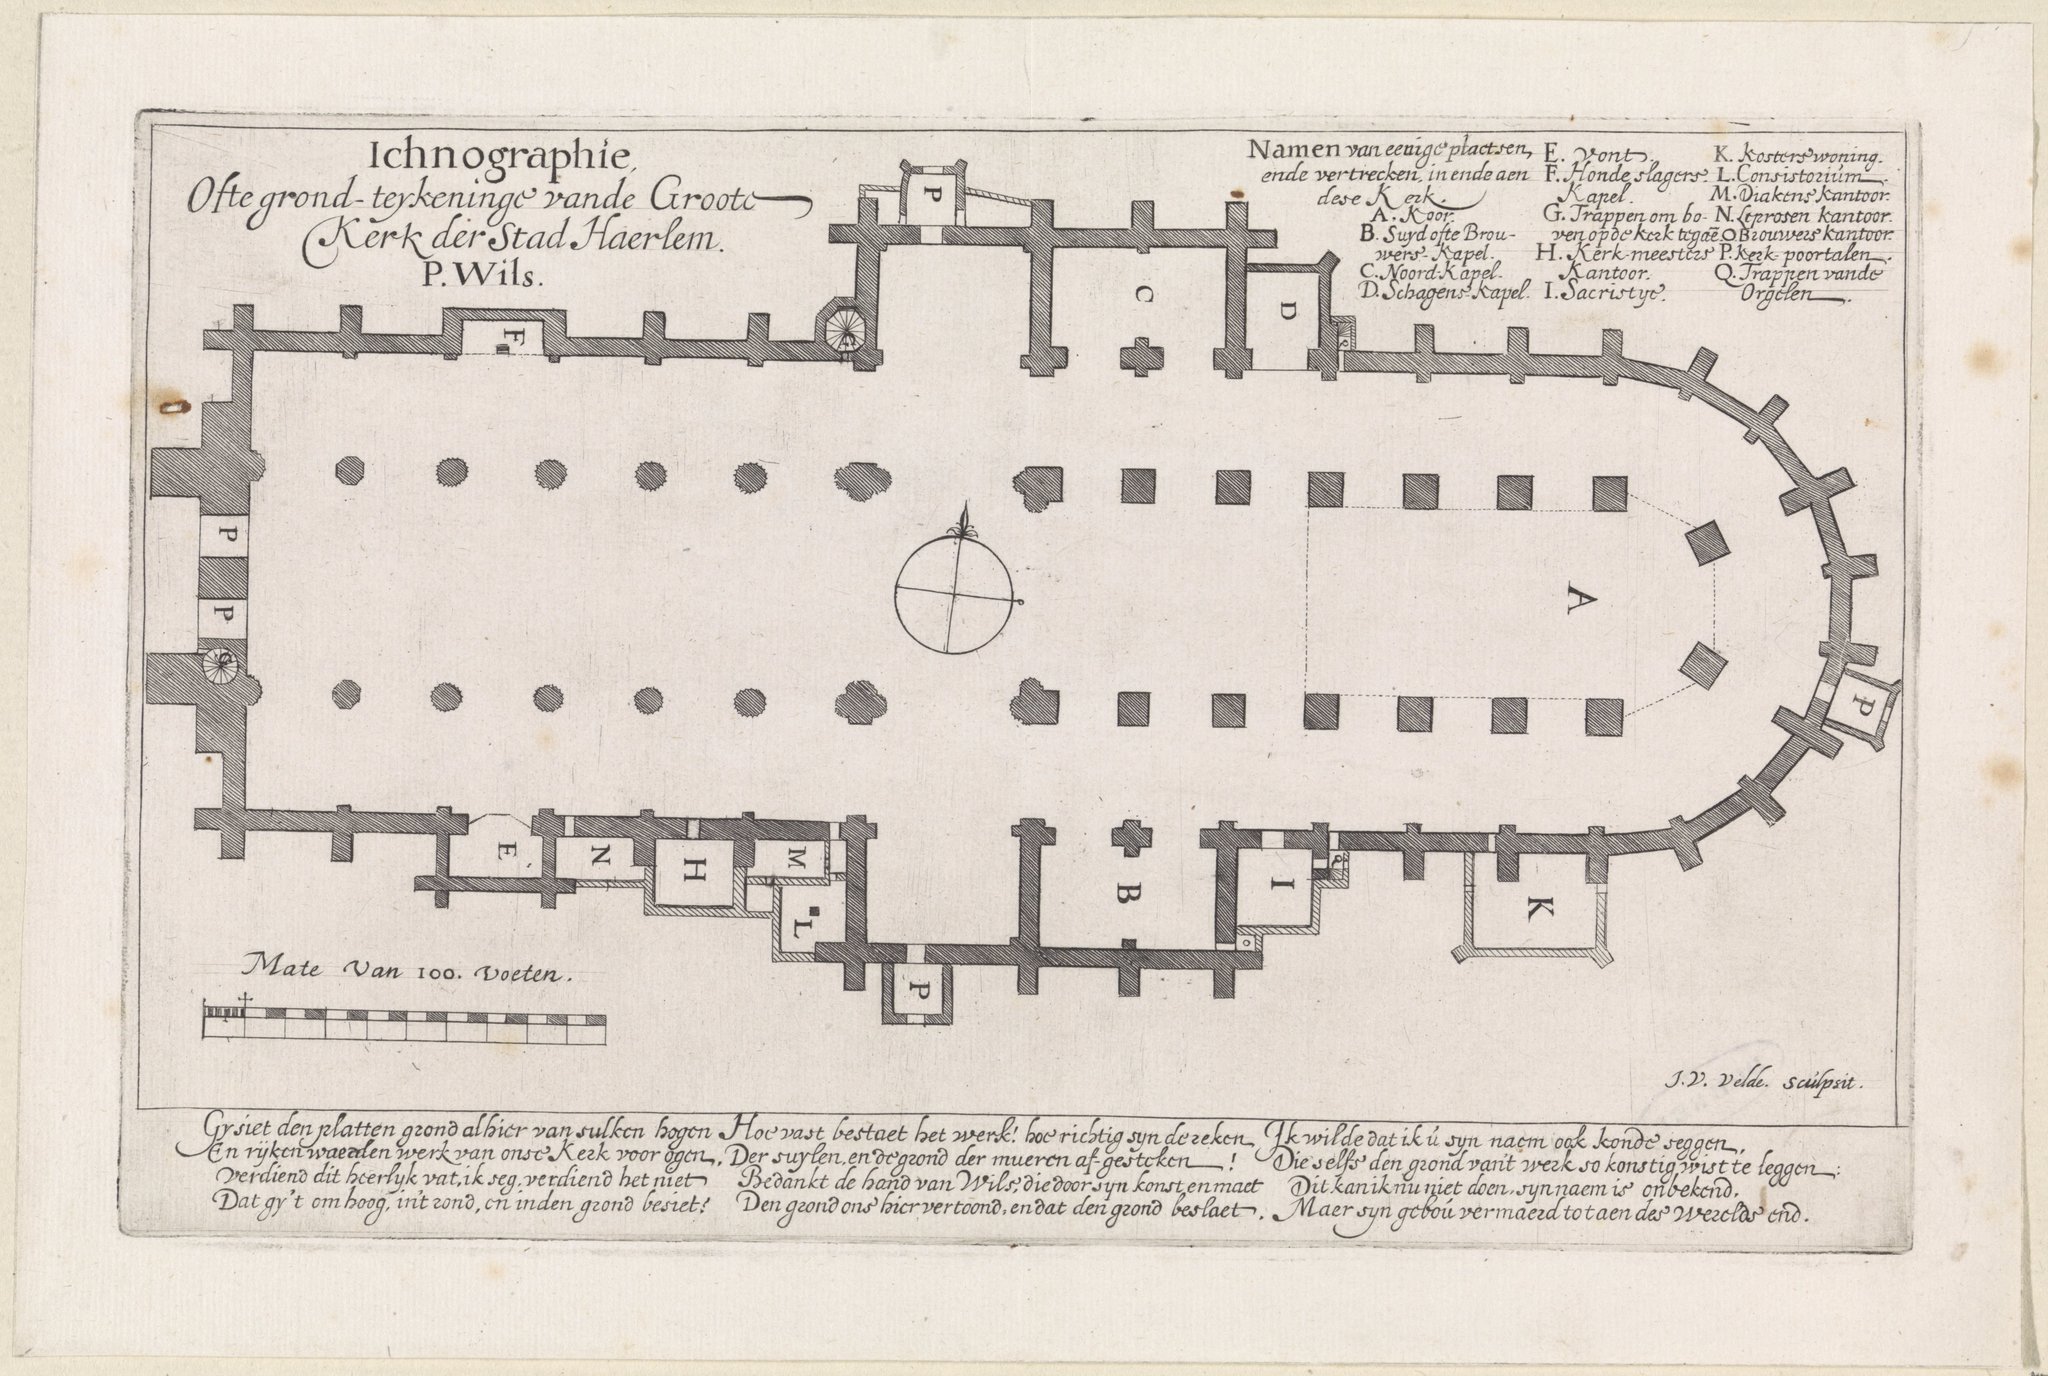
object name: area plan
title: Plattegrond van de Sint-Bavokerk te Haarlem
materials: paper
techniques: engraving, etching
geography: haarlem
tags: plan ~ architecture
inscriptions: collector's mark: Lugt 240, collector's mark: Lugt 698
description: Plattegrond van de Sint-Bavokerk te Haarlem. Linksboven de titel, linksonder een schaalstok: Mate van 100 voeten. Rechtsboven een legenda A-Q. Met een onderschrift van drie verzen van vier regels in het Nederlands.